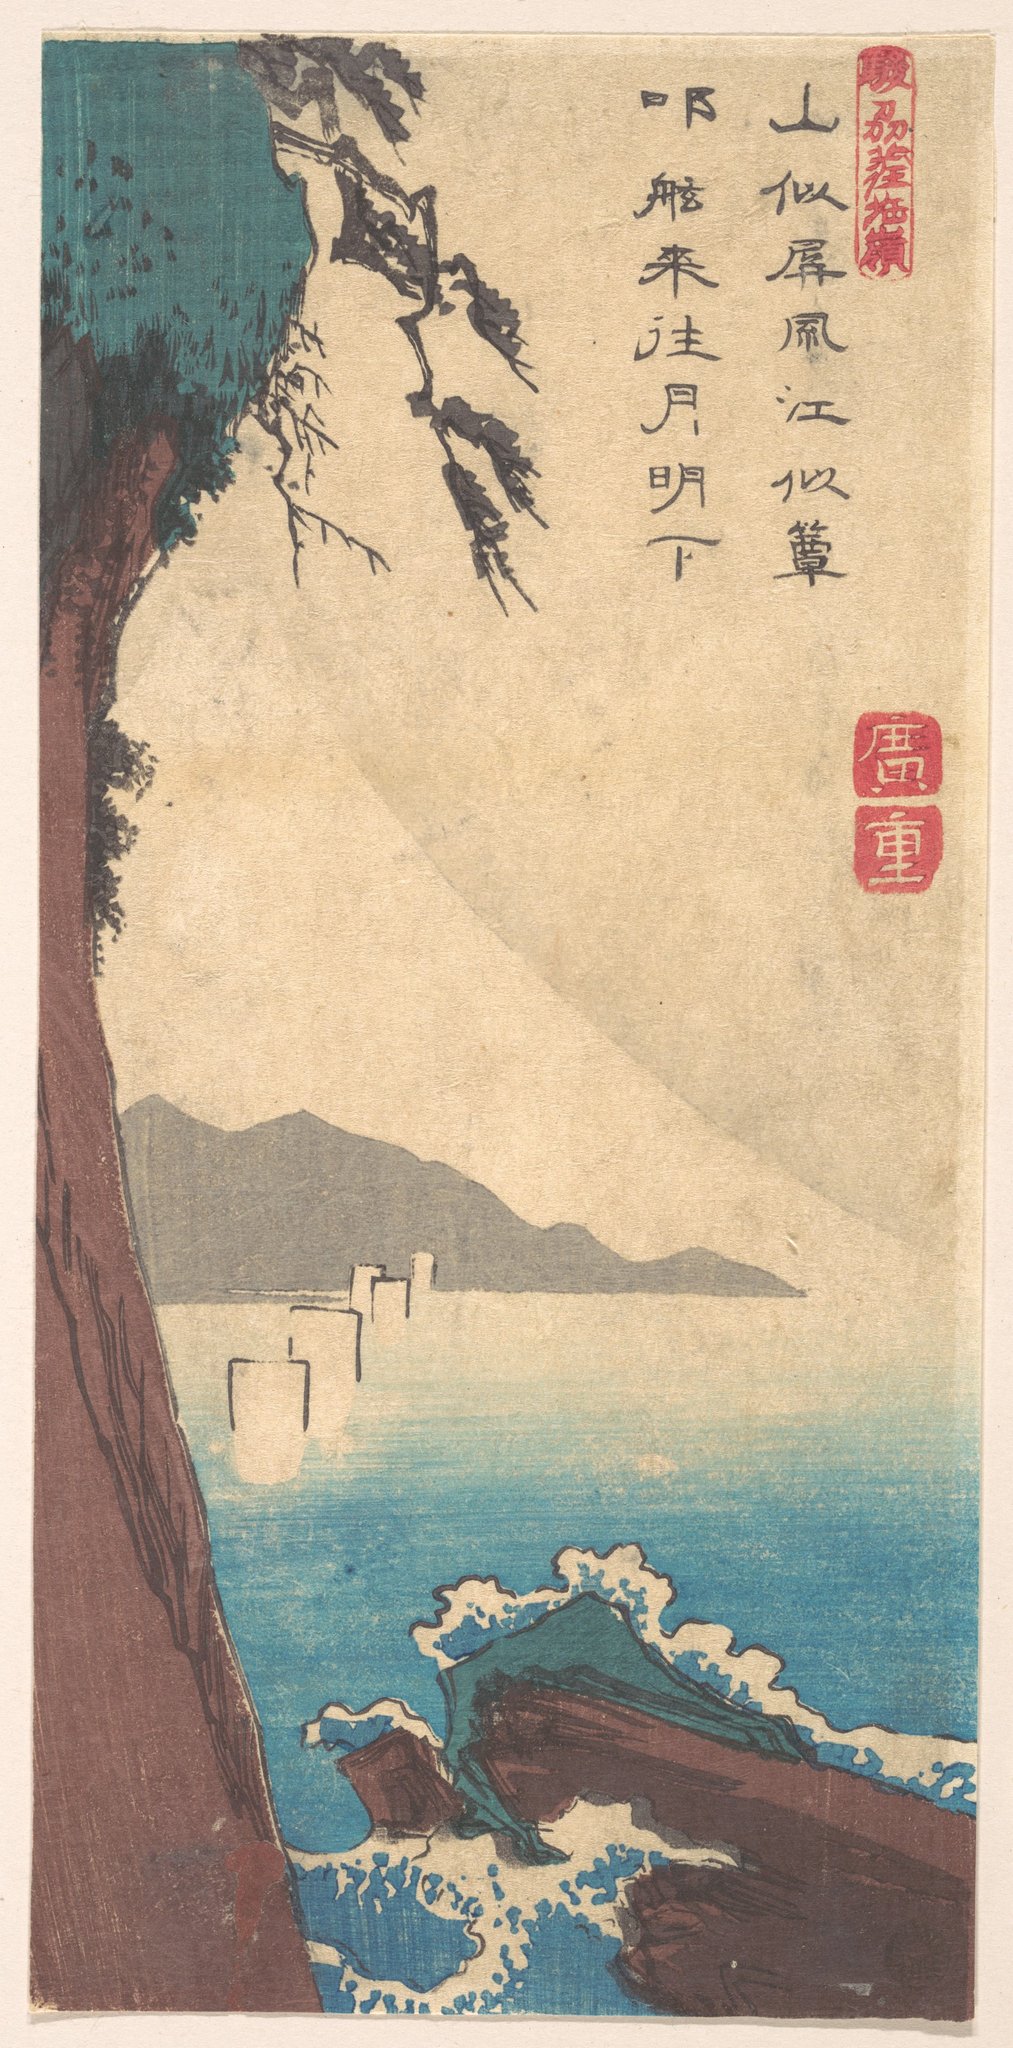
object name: print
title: The Satta pass, Province of Sunshu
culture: japanese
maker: utagawa hiroshige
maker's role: artist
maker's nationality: japanese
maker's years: 1797-1858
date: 1835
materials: ink, paper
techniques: woodblock print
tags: mountains,trees